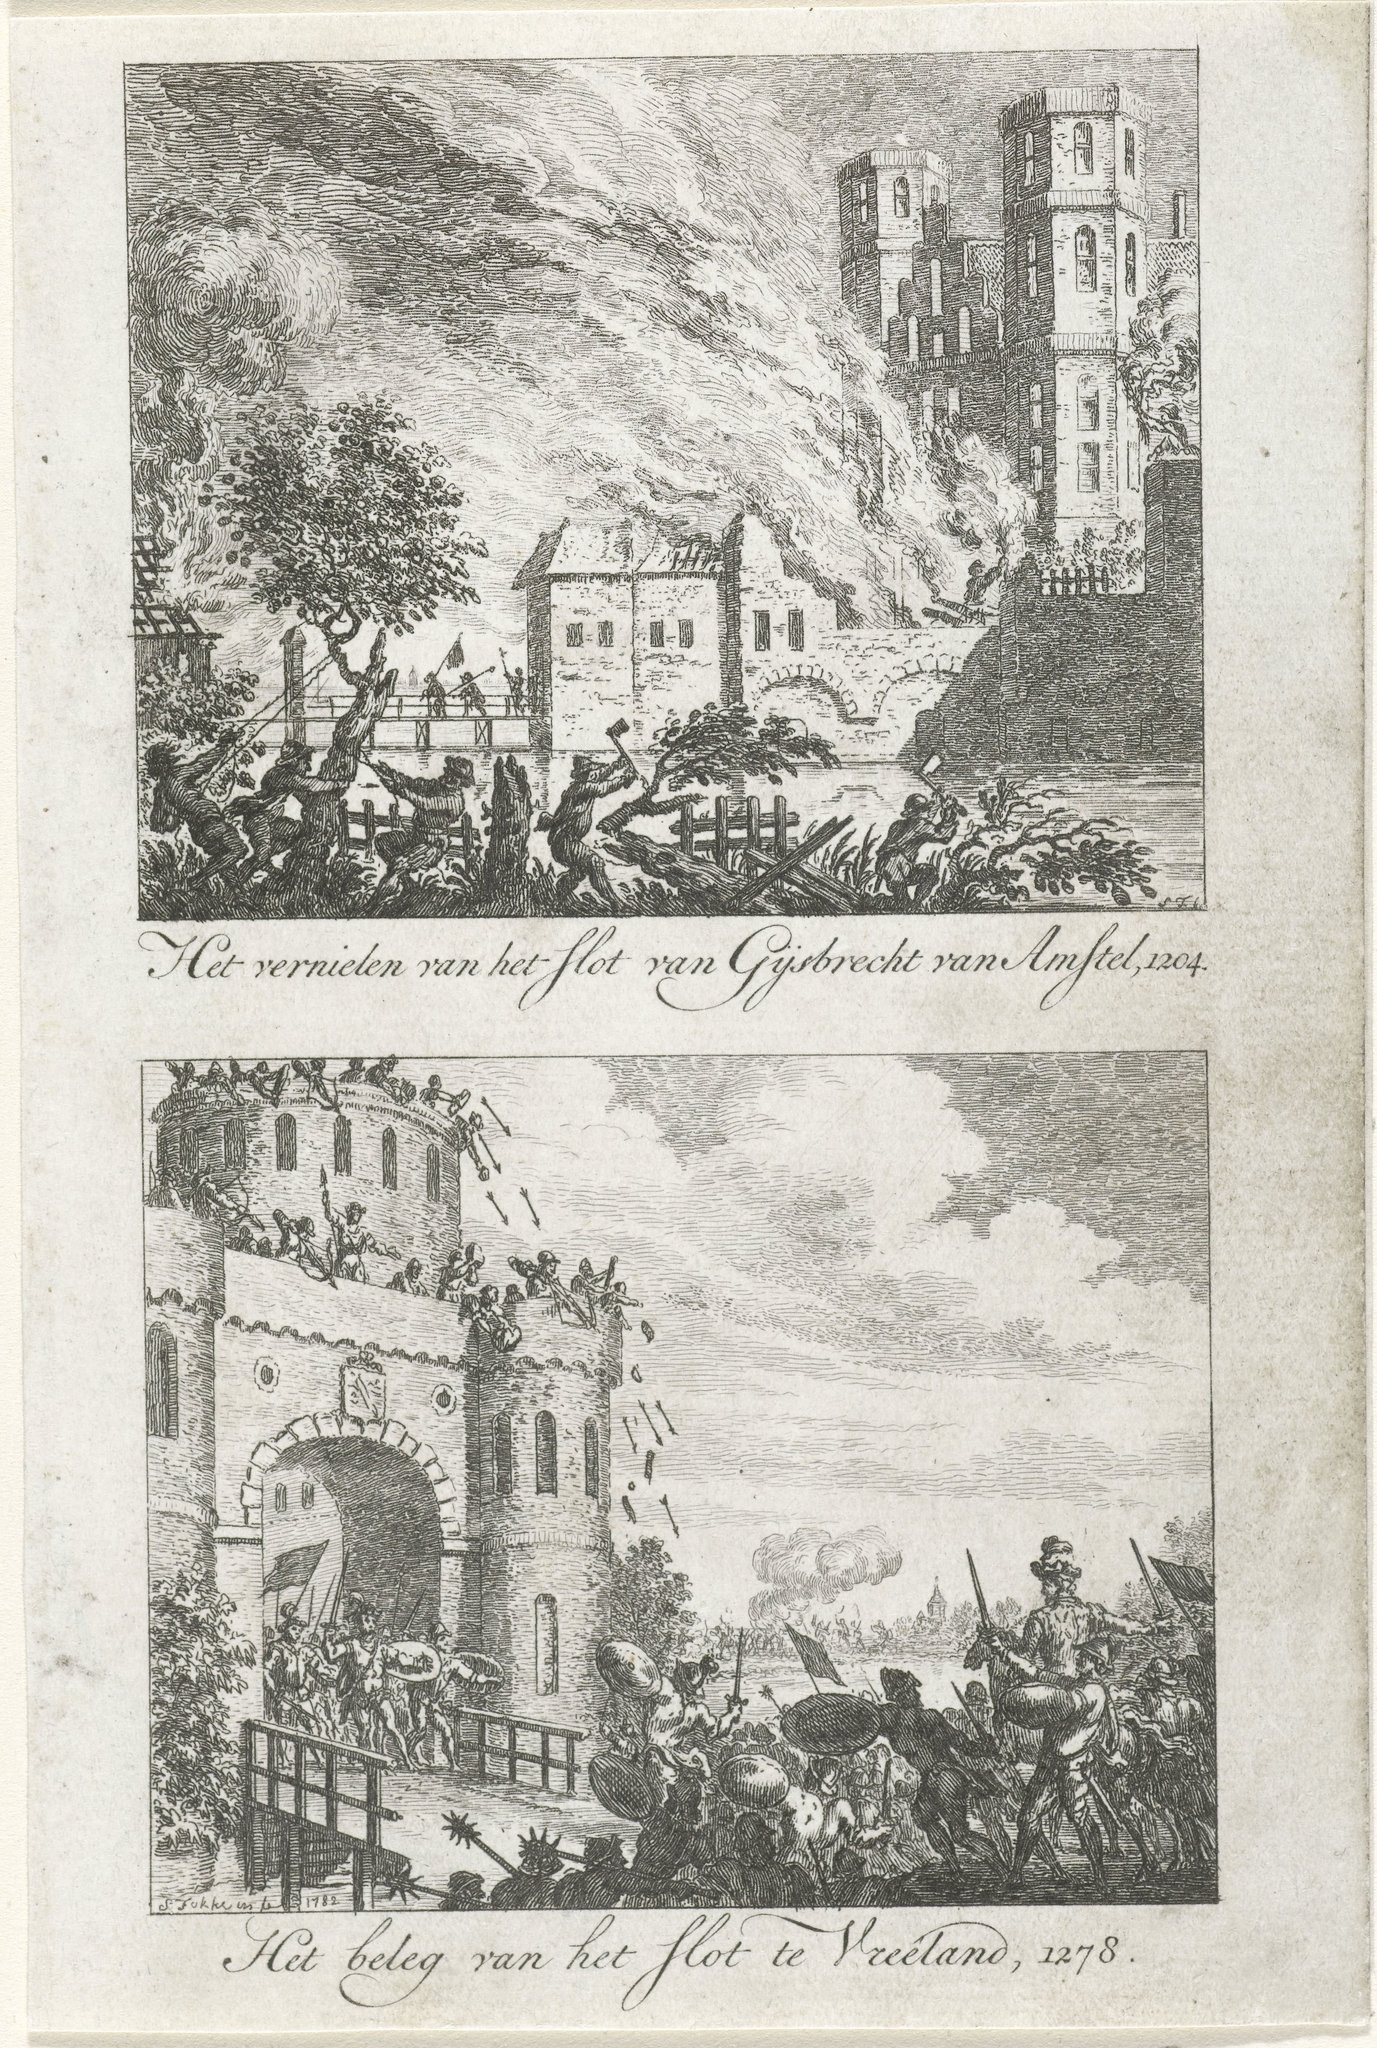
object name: print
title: Vernieling van het slot van Gijsbrecht II van Amstel, 1204, en beleg van het slot Vreeland, 1278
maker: simon fokke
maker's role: draughtsman, print maker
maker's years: 1712-1784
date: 1782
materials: paper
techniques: etching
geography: amsterdam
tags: leiden, floris v (graaf van holland en zeeland), siege, position war, destruction of buildings (~ revolutionary action)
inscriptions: collector's mark: Lugt 2228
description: Voorstellingen uit de vaderlandse geschiedenis. Boven: Terwijl het slot in brand staat, verlaten muitende figuren de vesting. Onder: Beleg van het slot Vreeland of Vredelant door graaf Floris V. Twee voorstellingen van één plaat.